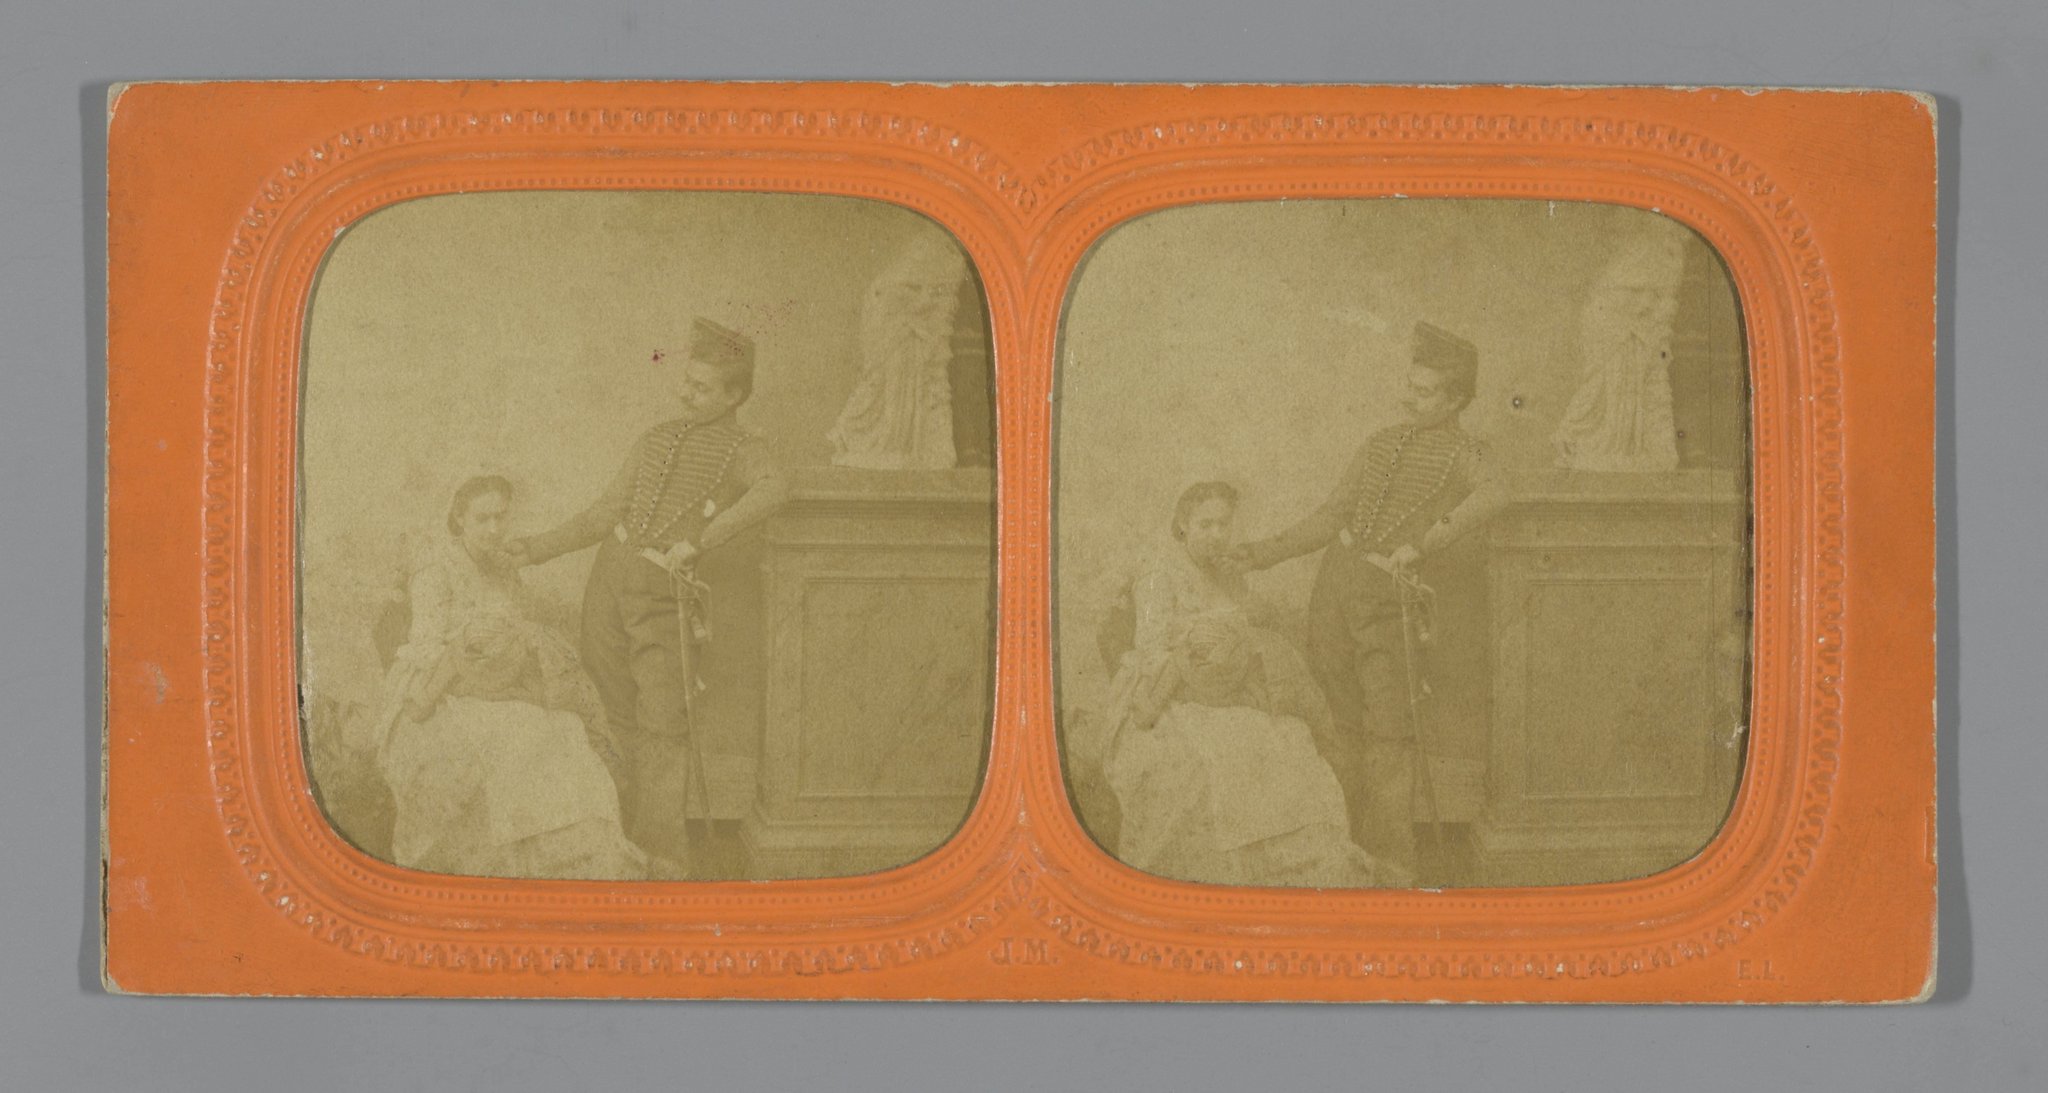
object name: tissue stereograph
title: Soldaat en jonge vrouw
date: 1864-1880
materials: cardboard, paper, photographic support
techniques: albumen print, hand coloring, perforating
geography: paris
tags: soldiers and civilians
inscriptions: number: ‘12’